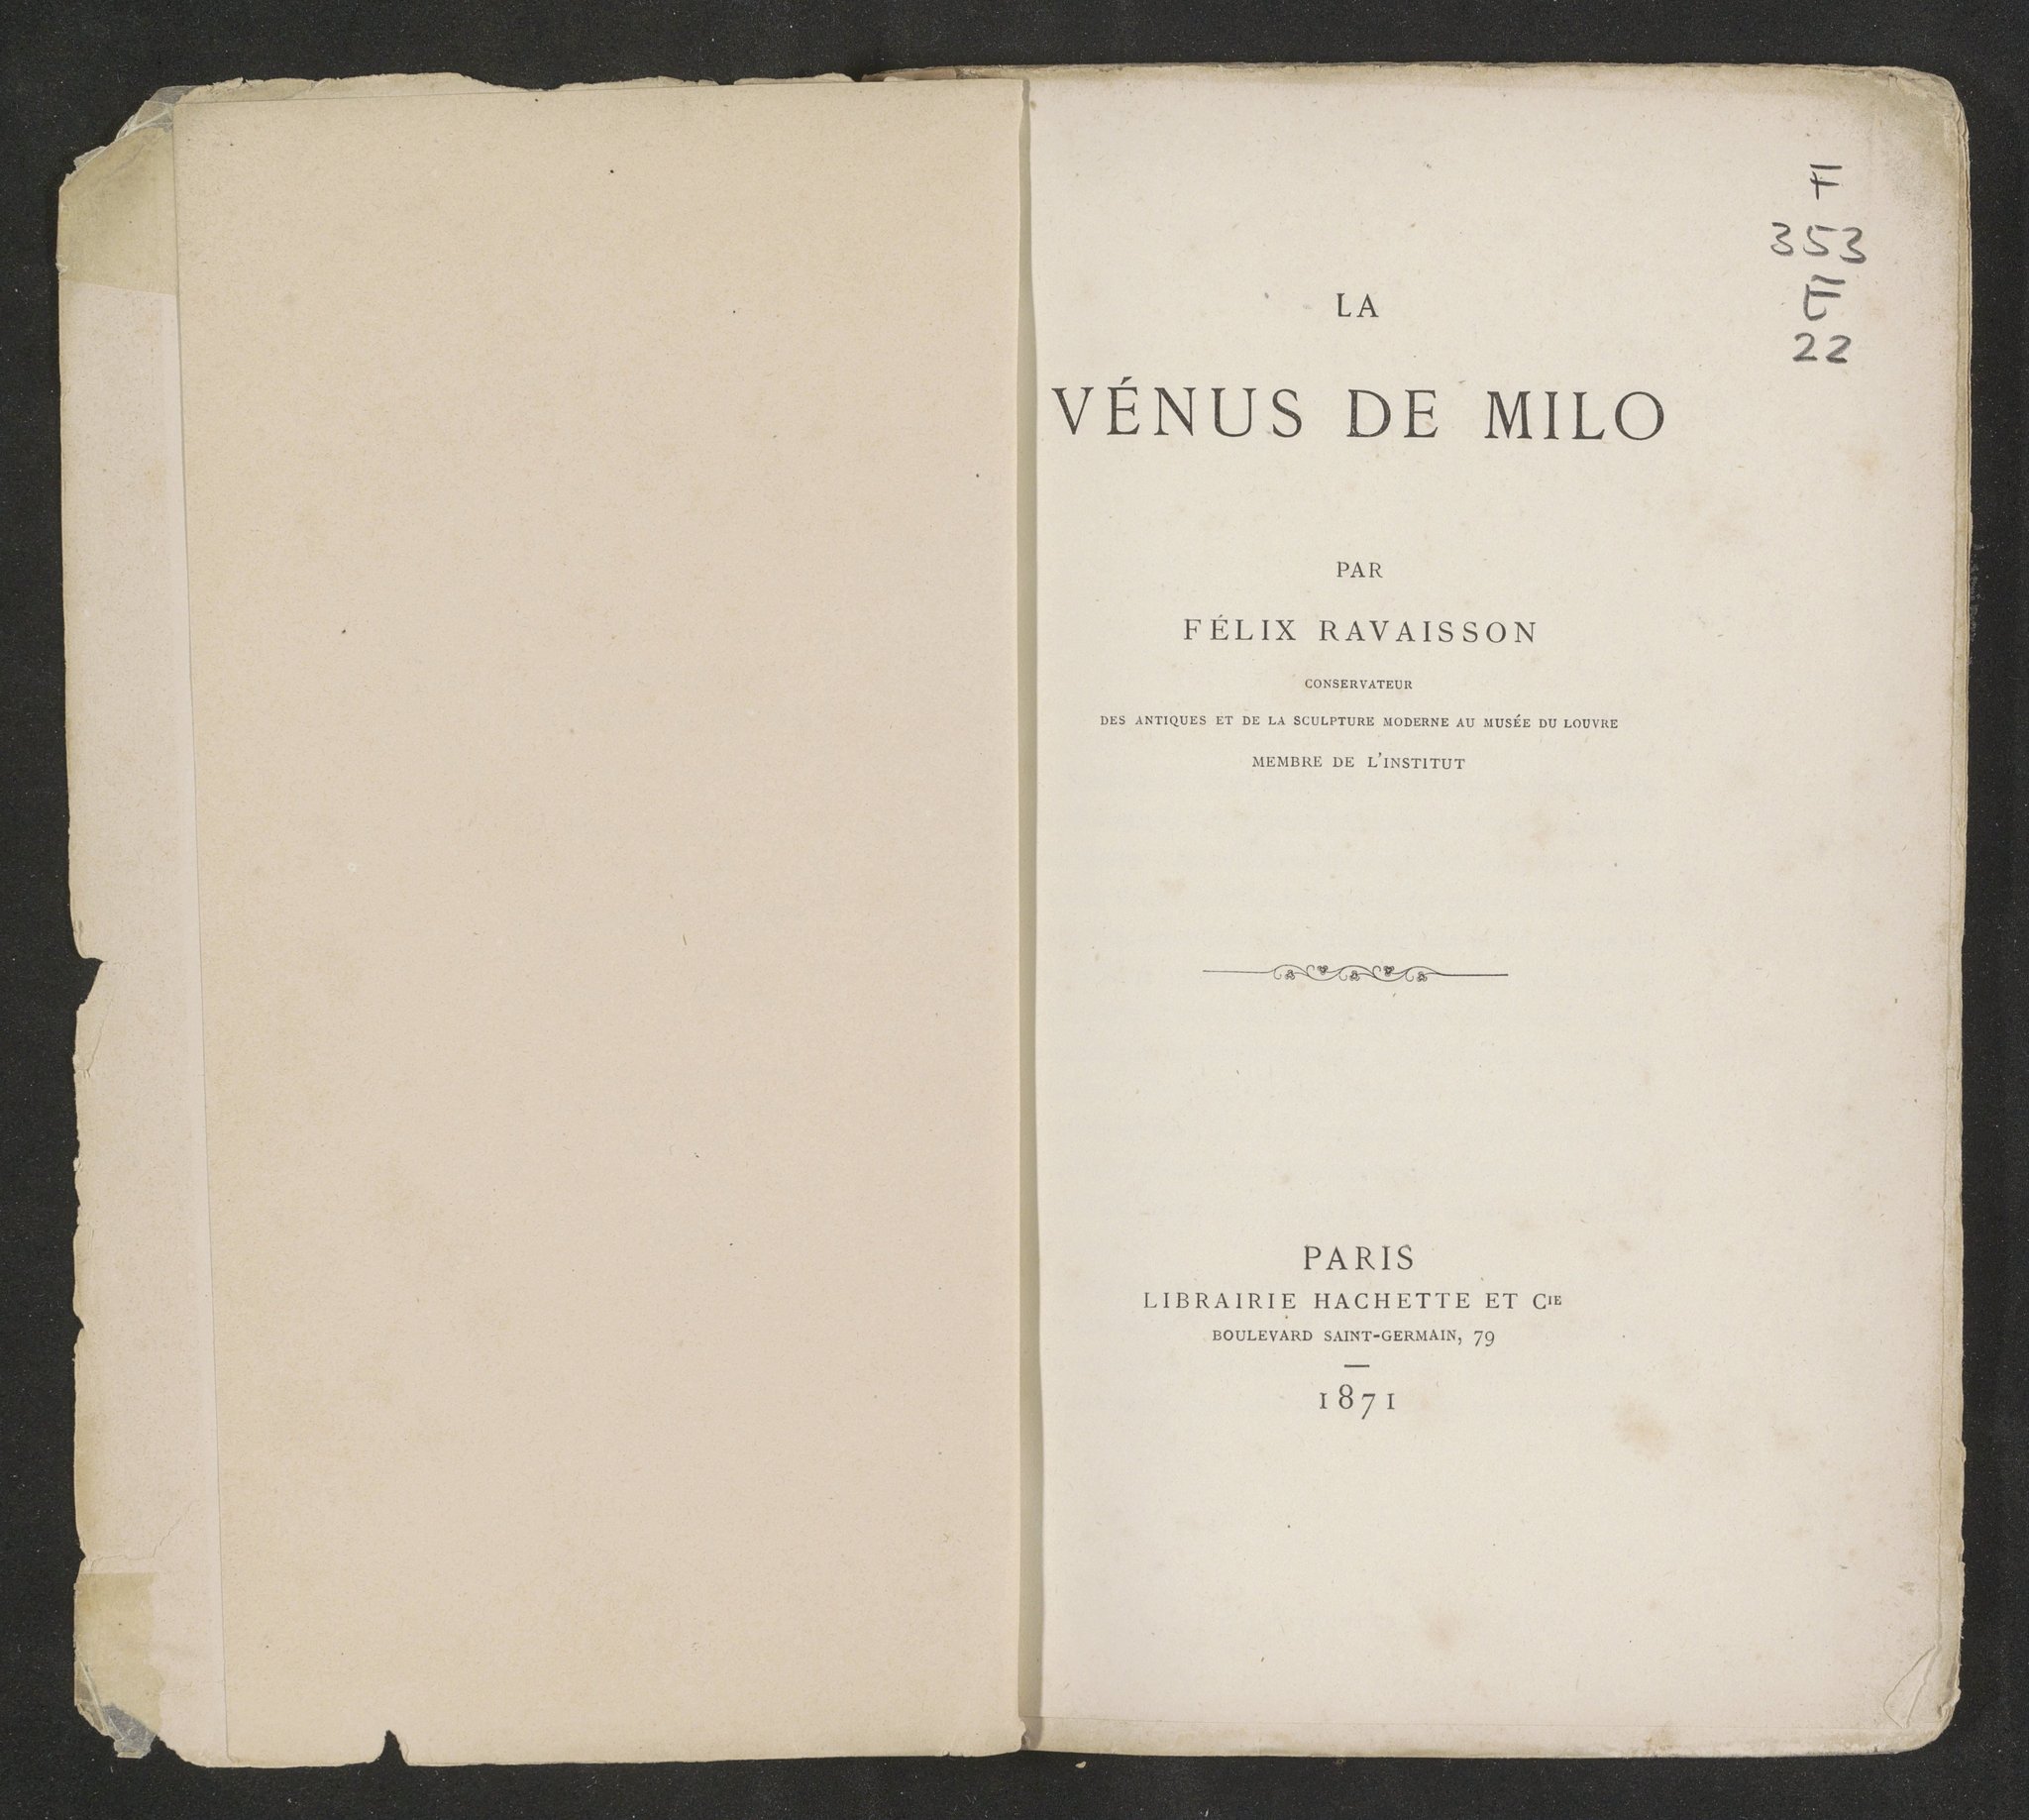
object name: book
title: La Vénus de Milo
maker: félix ravaisson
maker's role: archeoloog, conservator, filosoof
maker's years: 1813-1900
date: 1871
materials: paper, photographic support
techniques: albumen print, printing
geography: paris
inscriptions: inscription: ‘Sanatorium du Clergé de France (...) (Eccli. 18.6)’